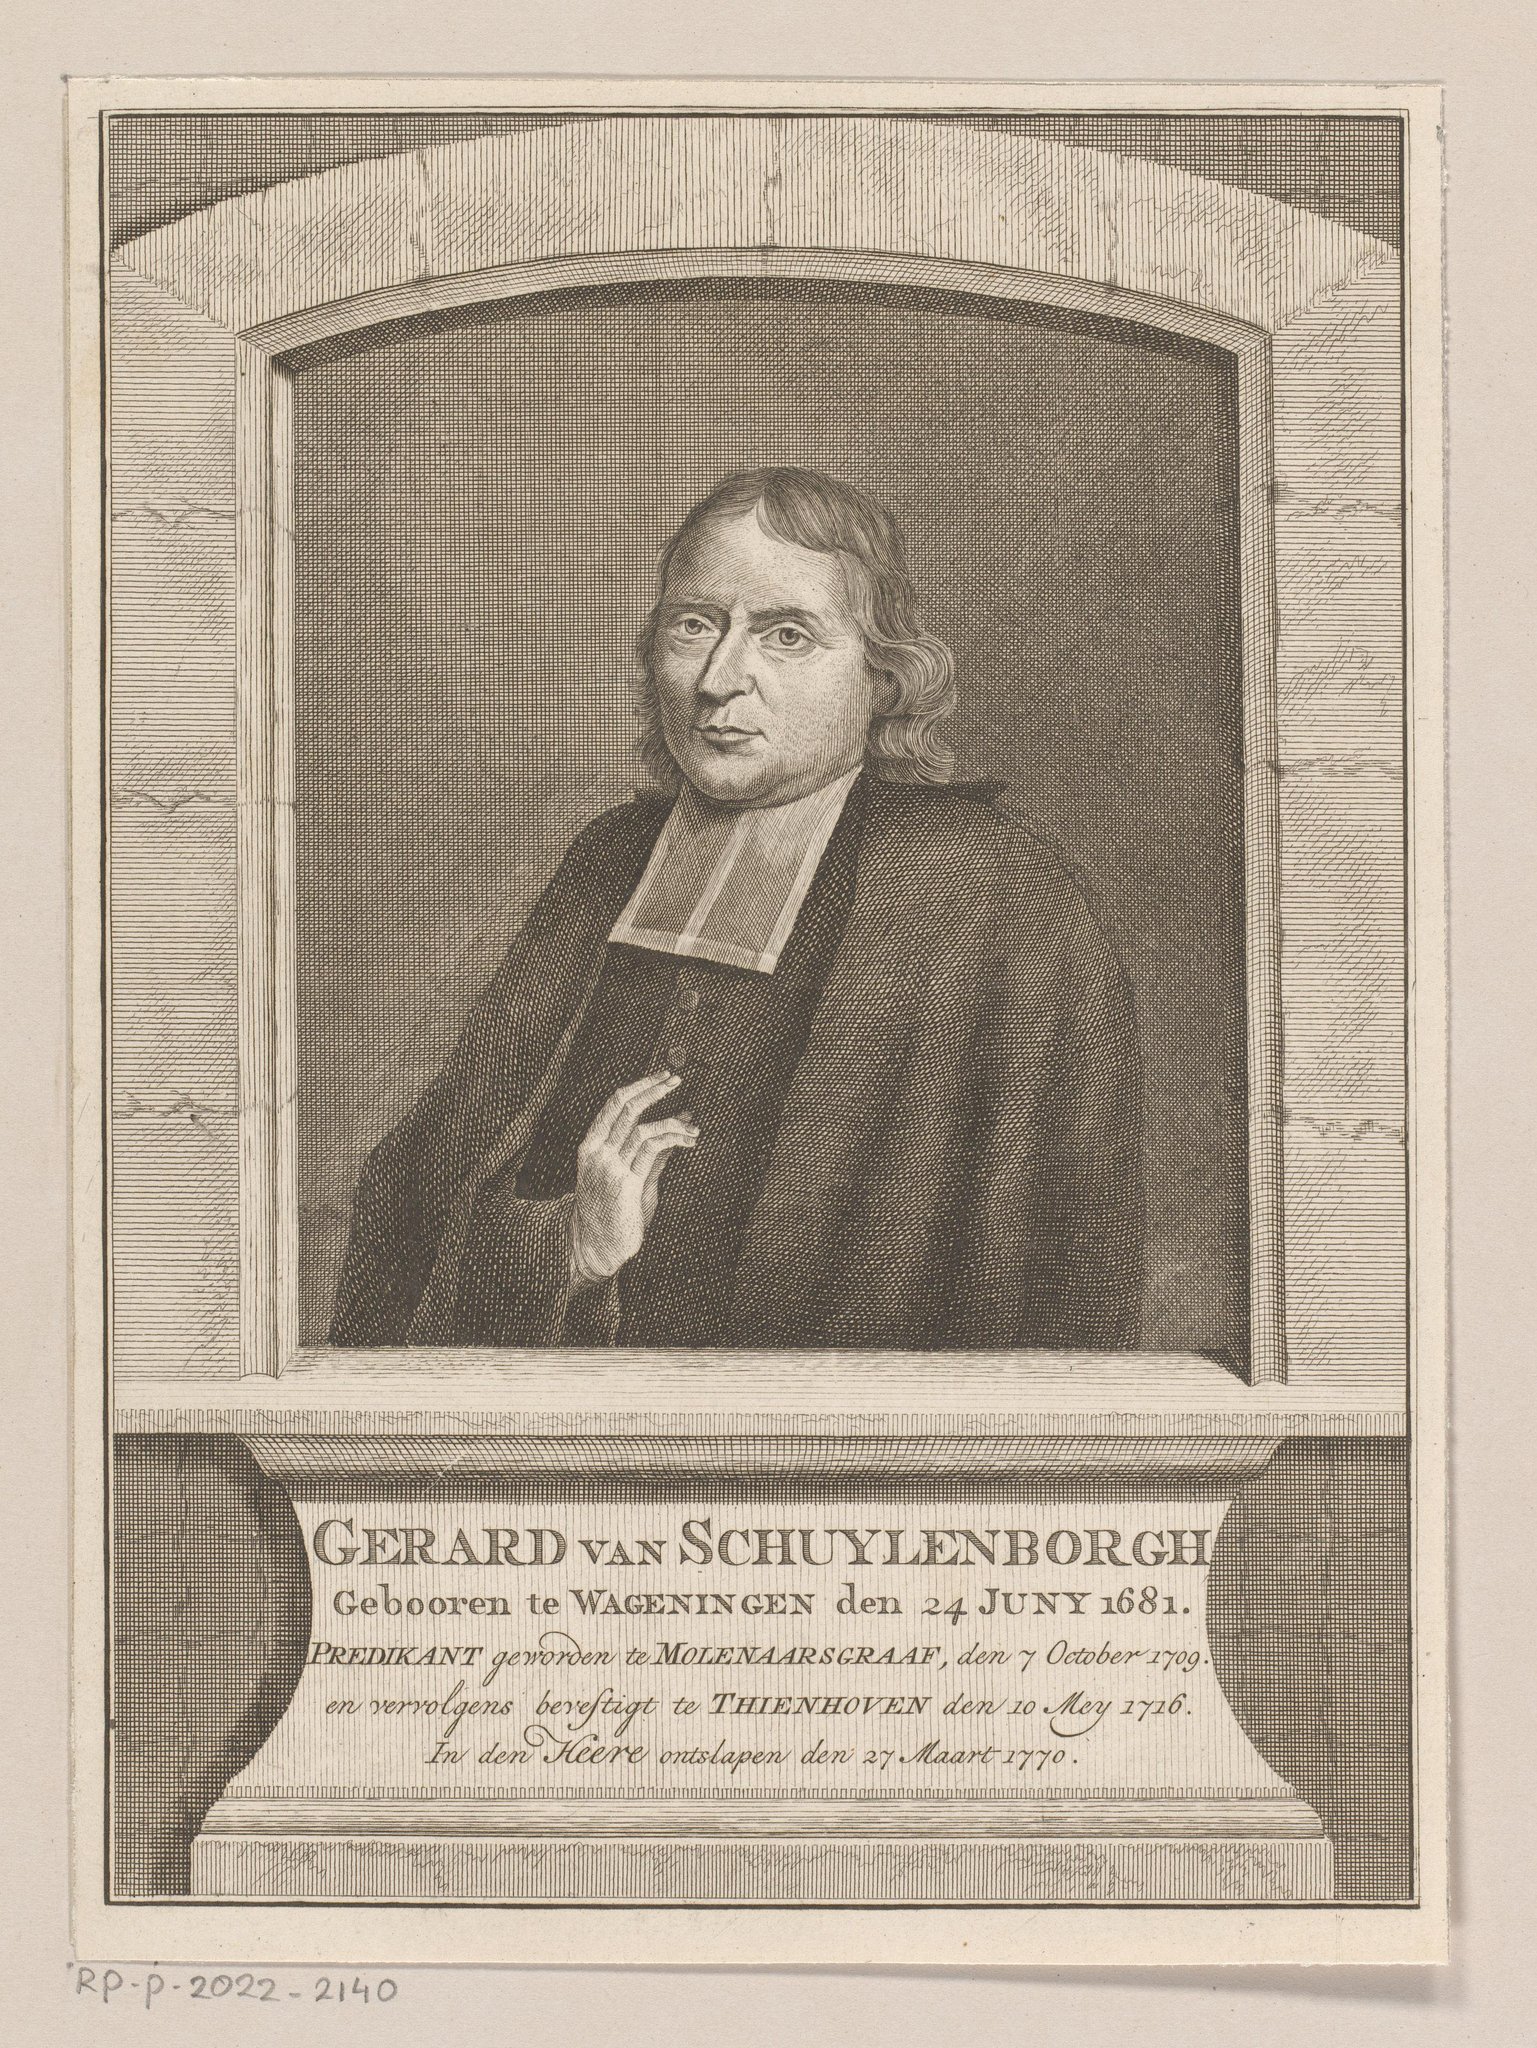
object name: print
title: Portret van Gerard van Schuylenborgh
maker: Anonymous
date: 1770-1799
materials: paper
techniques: engraving, etching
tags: historical persons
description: Met vijfregelig onderschrift in het Nederlands.